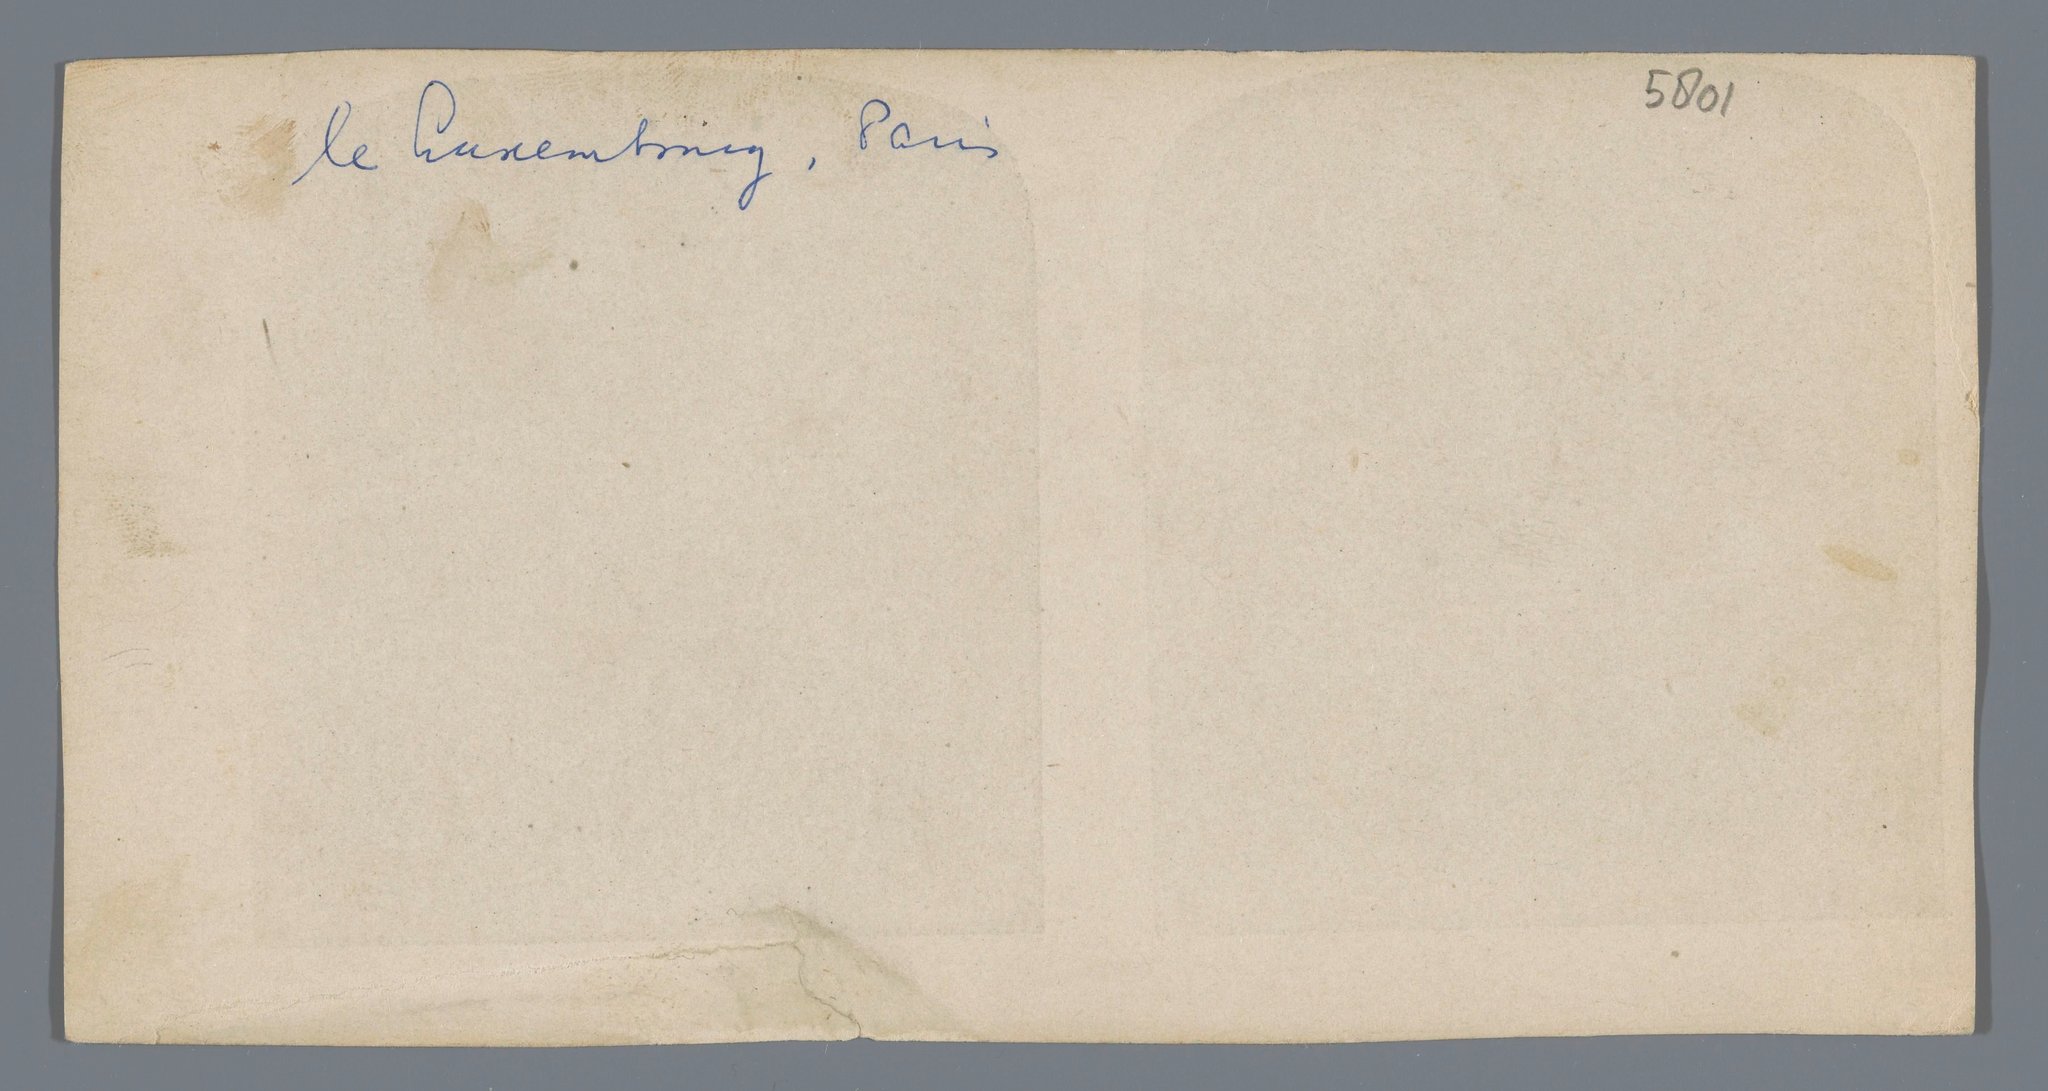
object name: stereograph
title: Gezicht op het Palais du Luxembourg in Parijs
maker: Anonymous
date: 1855-1860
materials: cardboard, photographic support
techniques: albumen print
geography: paris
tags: palace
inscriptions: inscription: ‘Le Luxembourg, Paris’